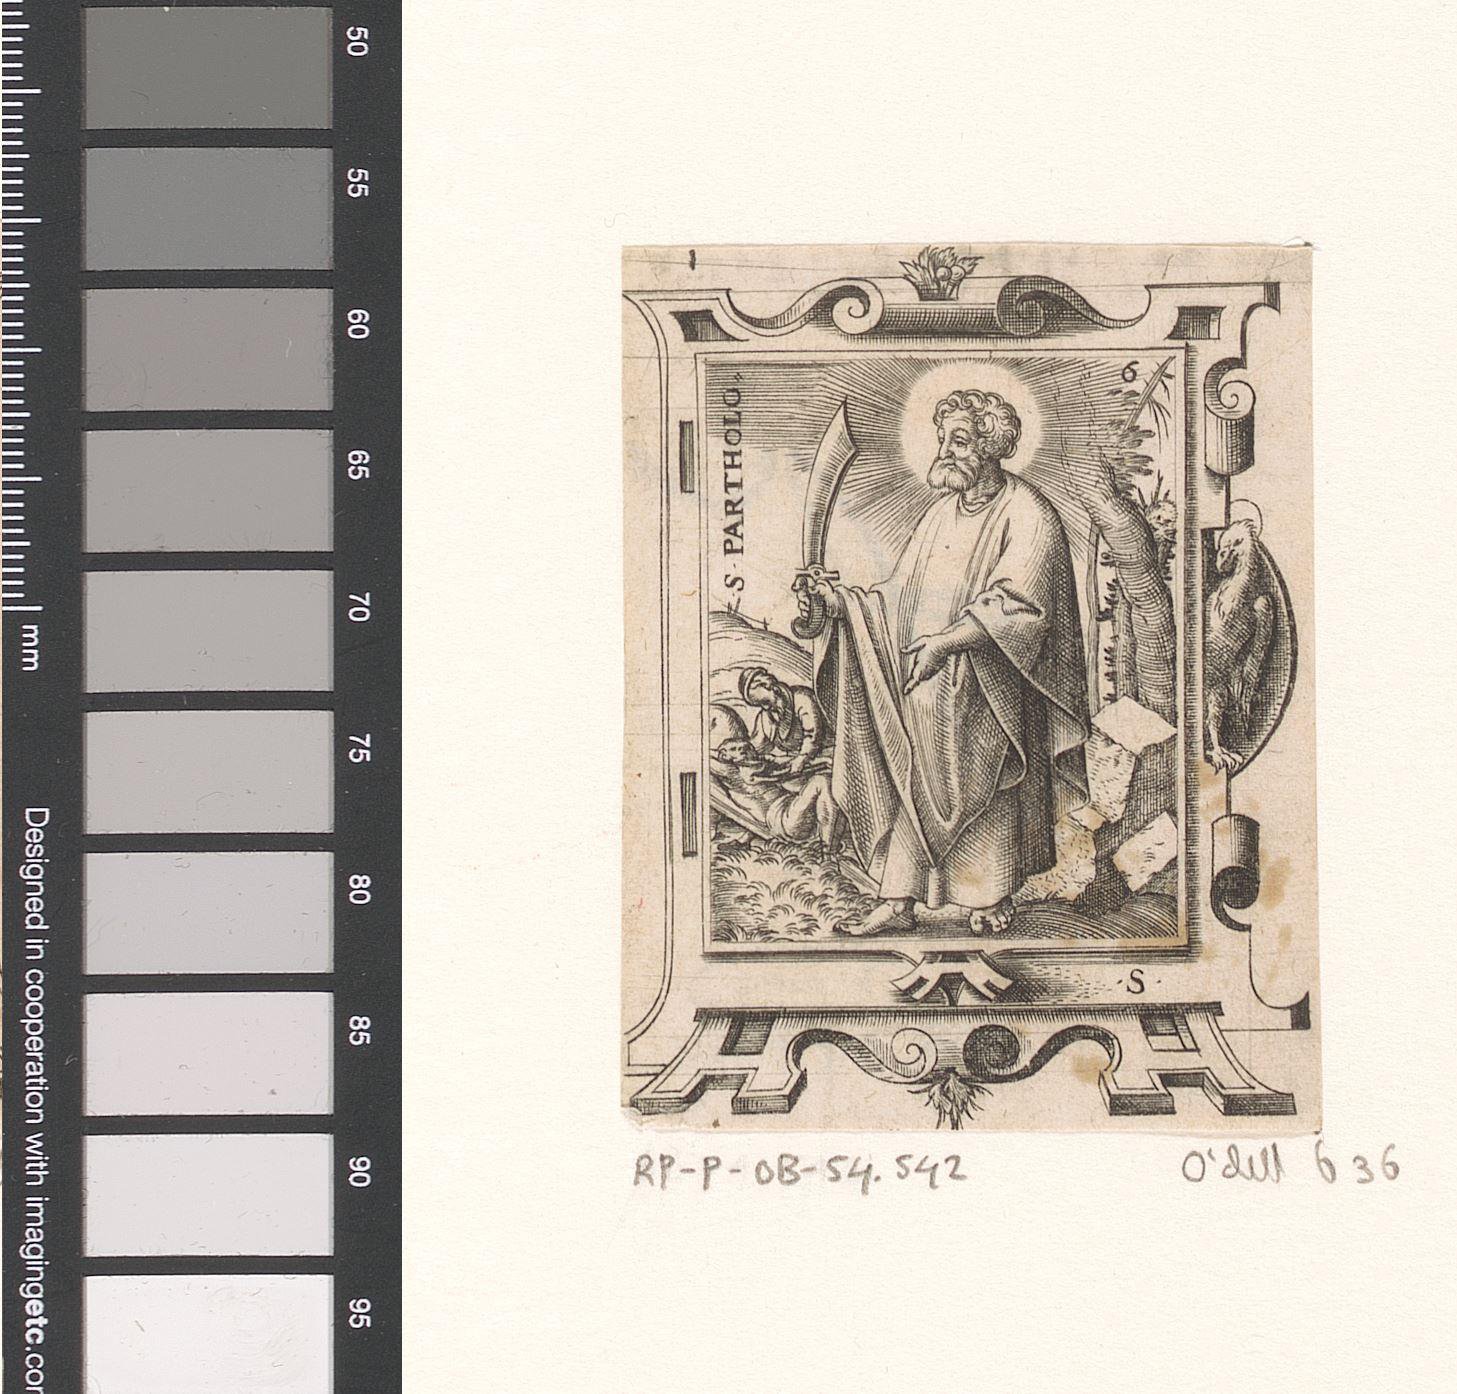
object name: print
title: Heilige Bartolomeüs in een rolwerk omlijsting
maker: virgilius solis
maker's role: draughtsman, print maker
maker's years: 1514-1562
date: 1568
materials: paper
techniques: engraving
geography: nuremberg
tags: the apostle bartholomew; possible attributes: book, devil or dragon at feet, knife, scroll, flayed skin, staff, scrollwork, strapwork ~ ornament, bartholomew flayed alive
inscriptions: collector's mark: Lugt 240, collector's mark: Lugt 2228, number: ‘87’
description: Prent gebruikt voor het gebedenboek: Solis, Virgil. Ein New Künstlich Betbüchlein. Neurenberg: Hieronymus Petri, 1568. Bij elke prent met afbeelding van een apostel behoort een prent met een gebed in het Latijn en in het Duits. Bij elkaar horende prenten hebben dezelfde nummering en het monogram VS is steeds verspreid over twee bladen met dezelfde nummering.